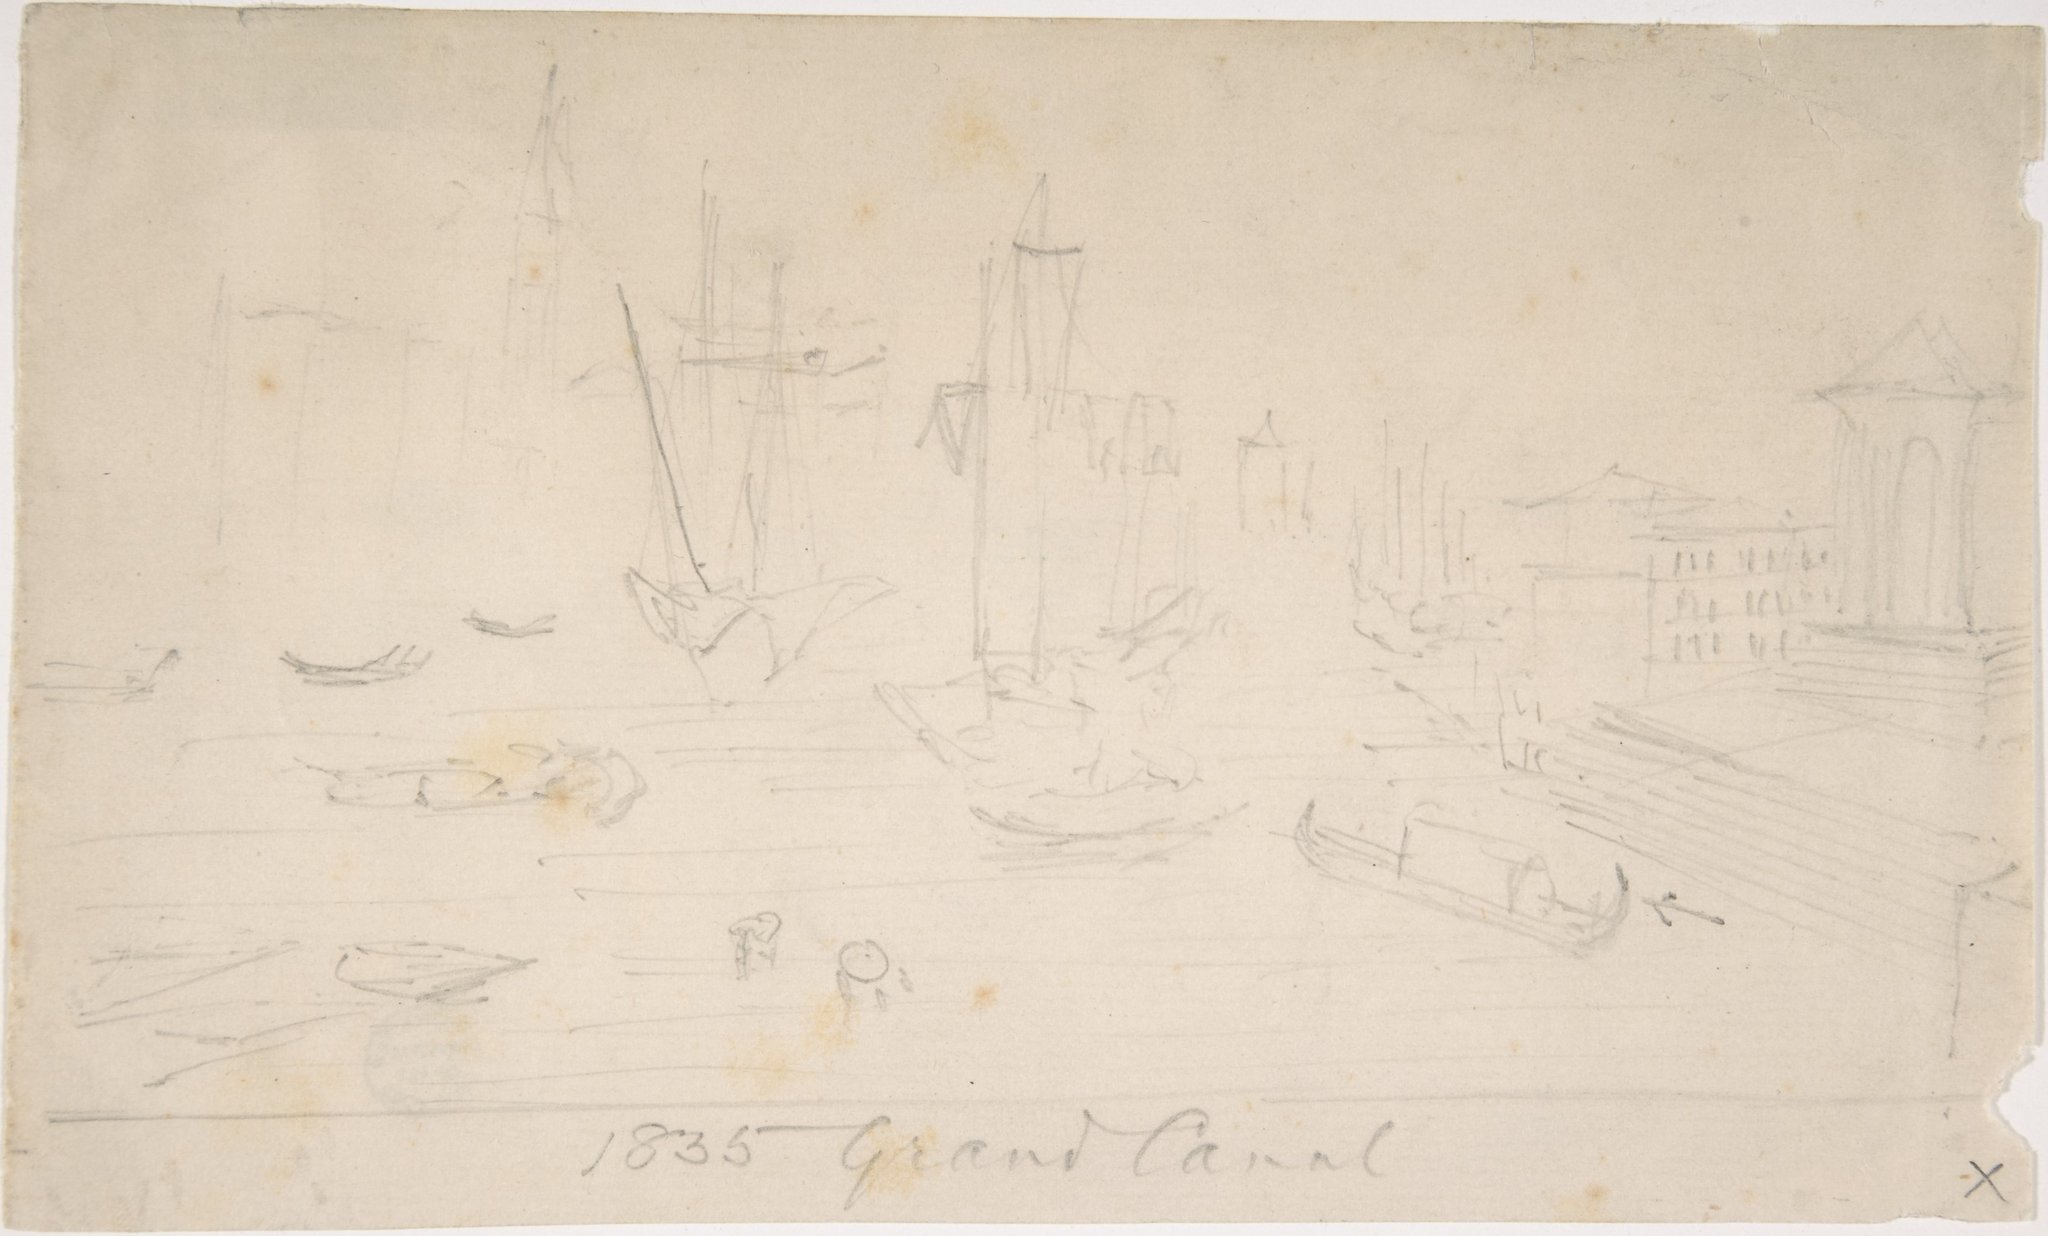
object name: drawing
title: Grand Canal, Venice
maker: anonymous, 19th century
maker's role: artist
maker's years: 1800-1900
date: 1851-1900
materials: graphite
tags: canals,boats,venice